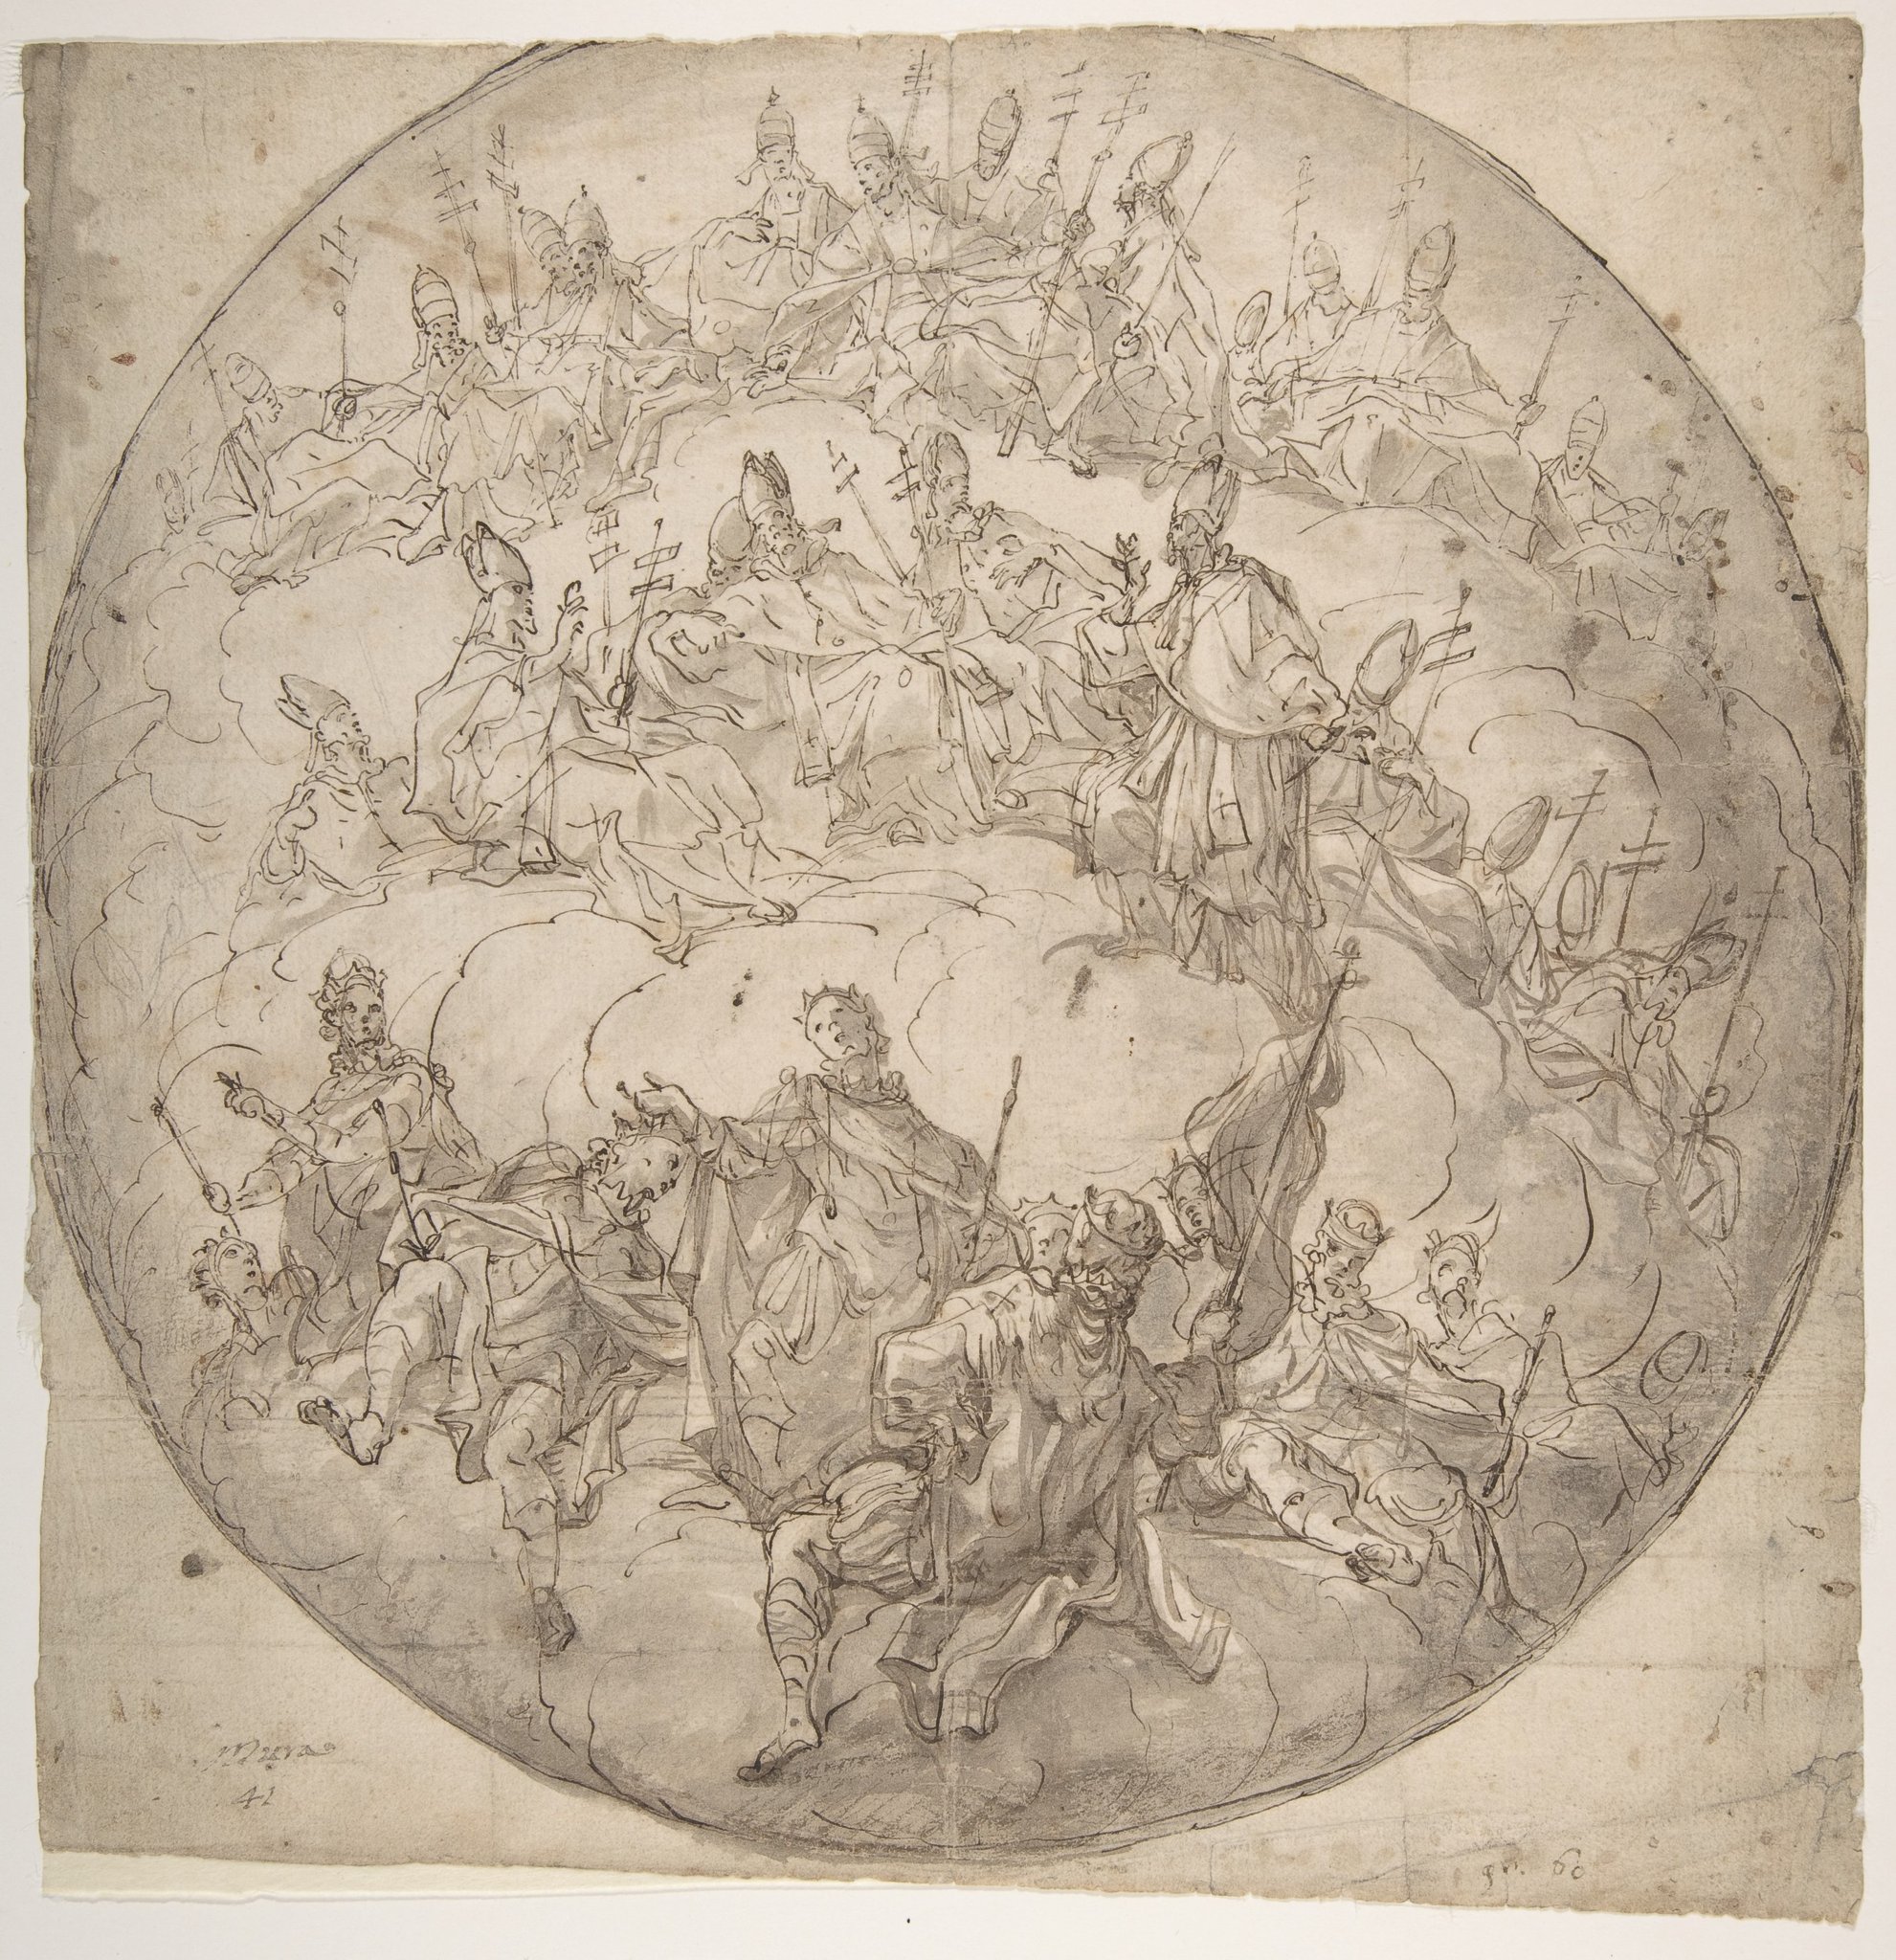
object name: drawing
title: Kings, Bishops and Popes: design for ceiling.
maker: francesco de mura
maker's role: artist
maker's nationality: italian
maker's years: 1696-1782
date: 1696-1782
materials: ink, paper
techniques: pen, wash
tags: kings,bishops,popes